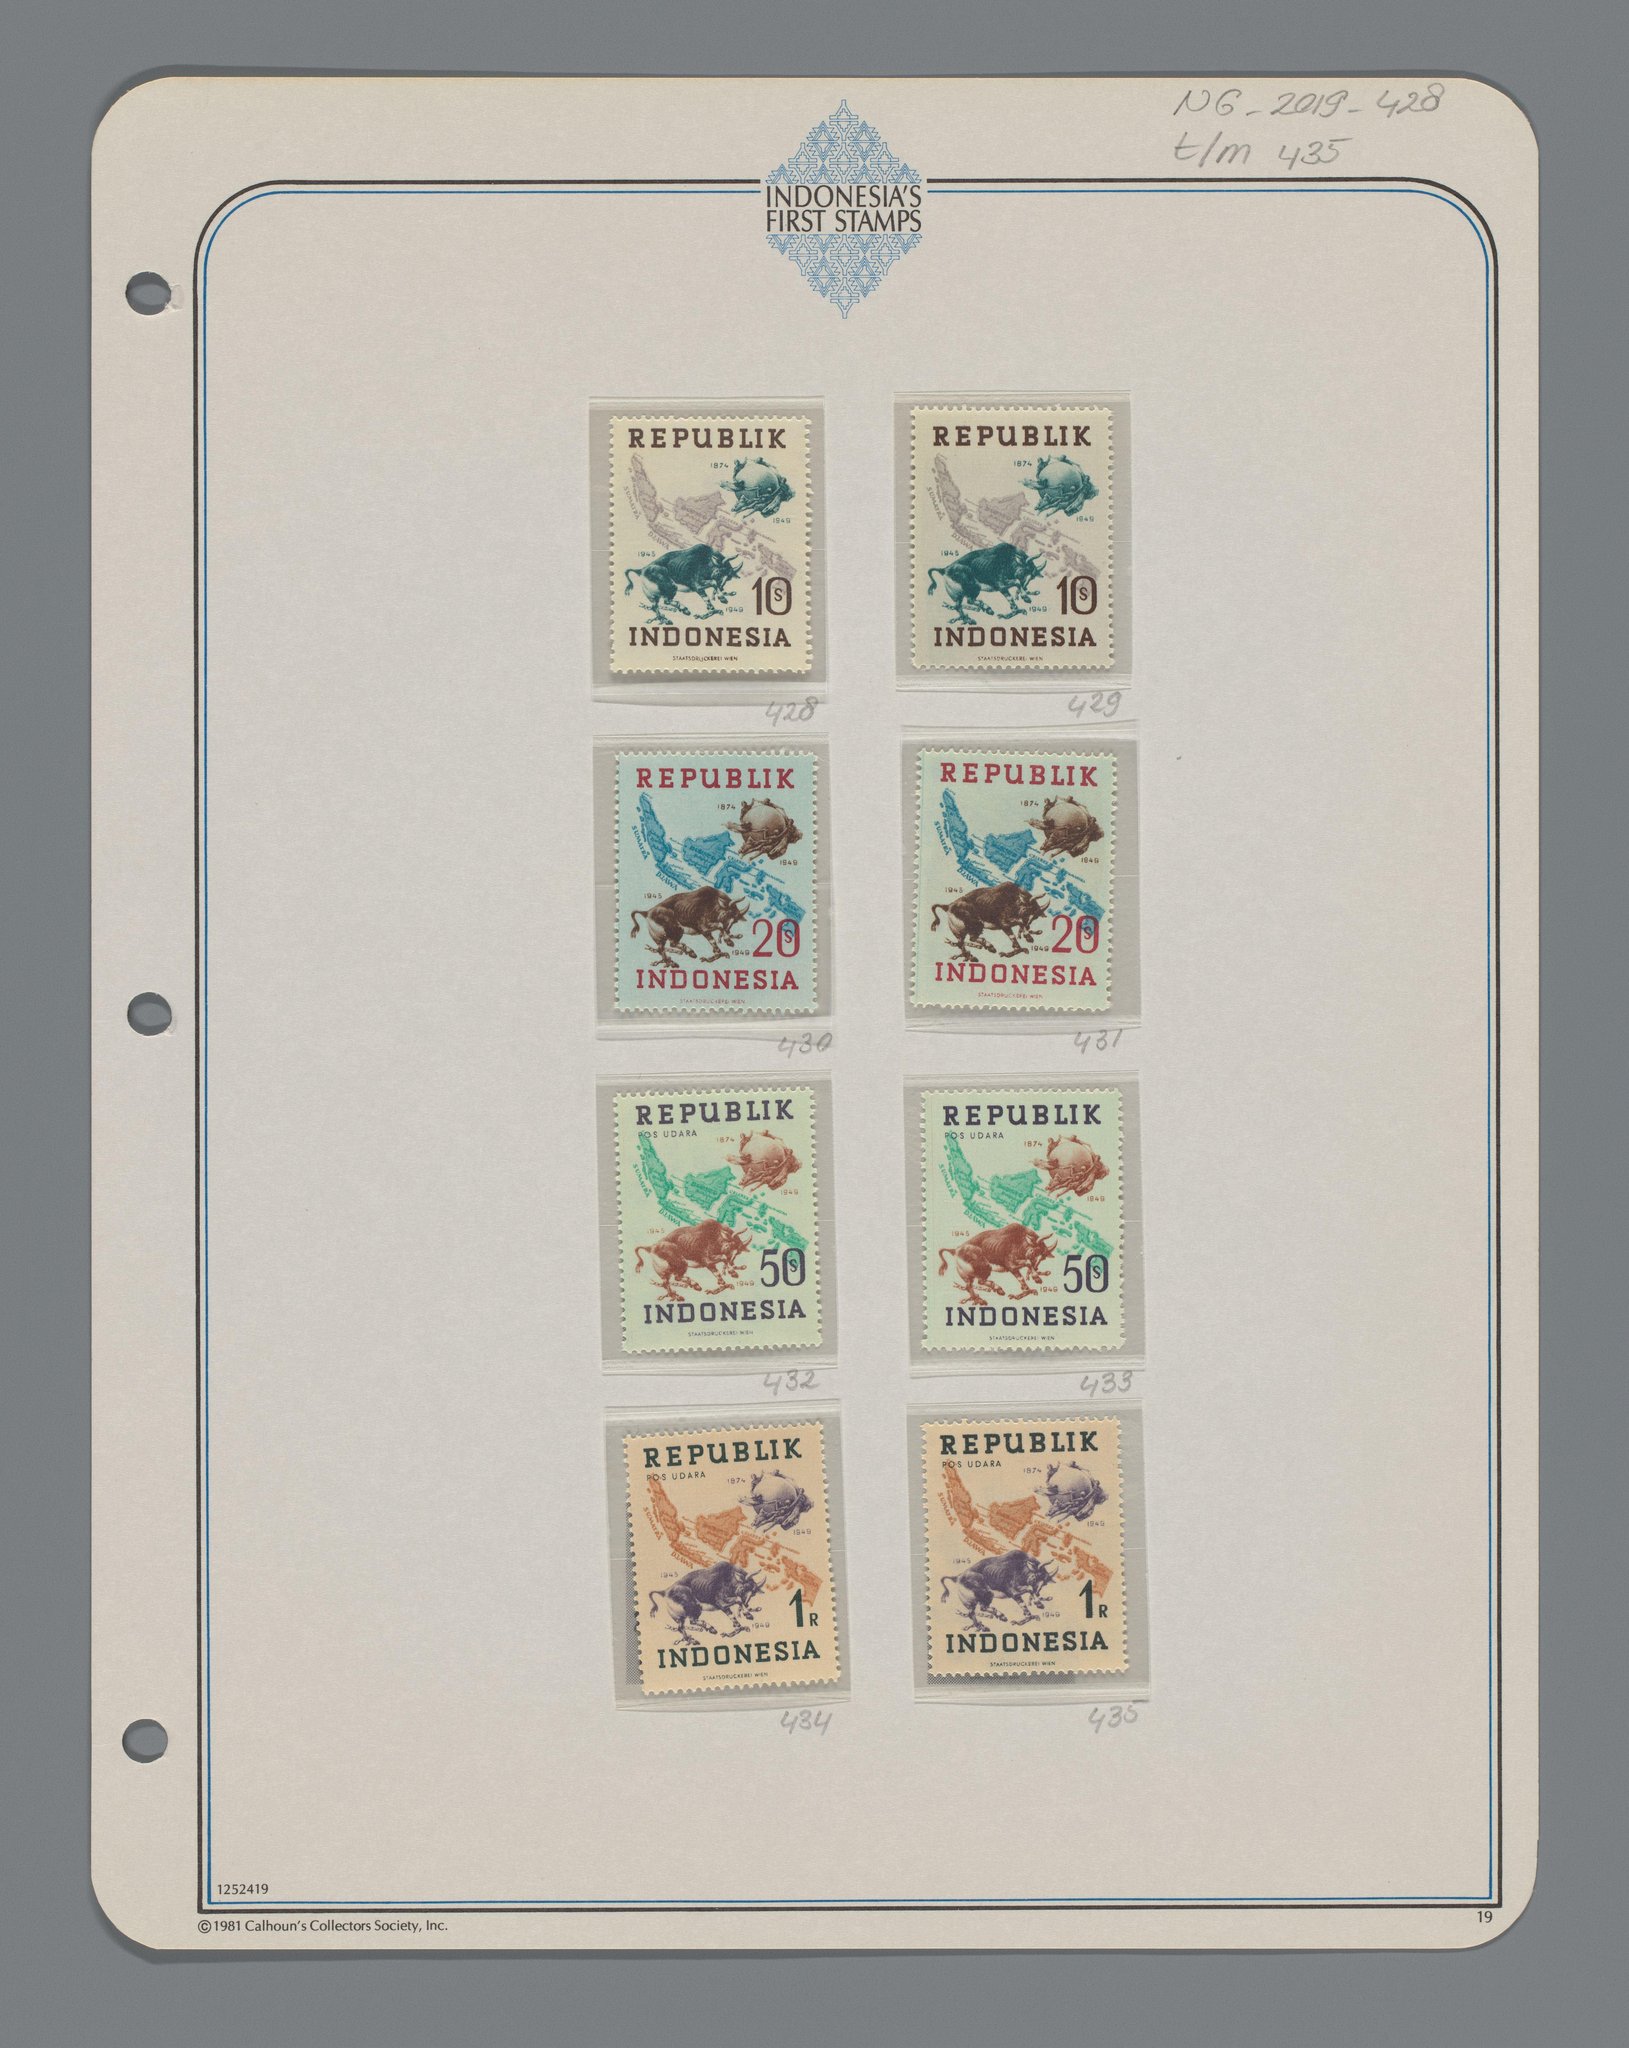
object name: postage stamp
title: Postzegel Republik Indonesia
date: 1949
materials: paper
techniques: photoaquatint, engraving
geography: vienna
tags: indonesia